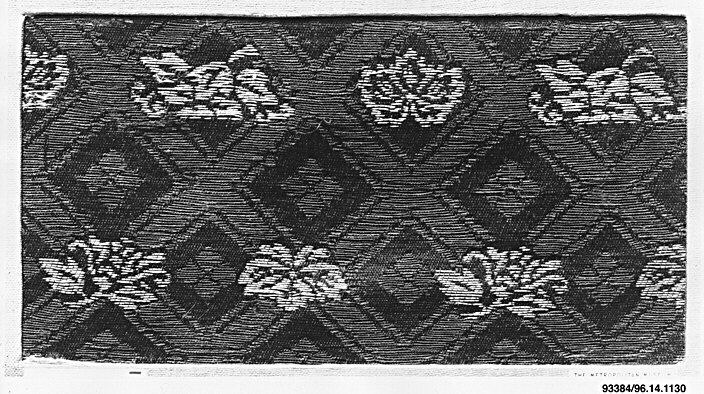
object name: piece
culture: japanese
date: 1701-1900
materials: silk